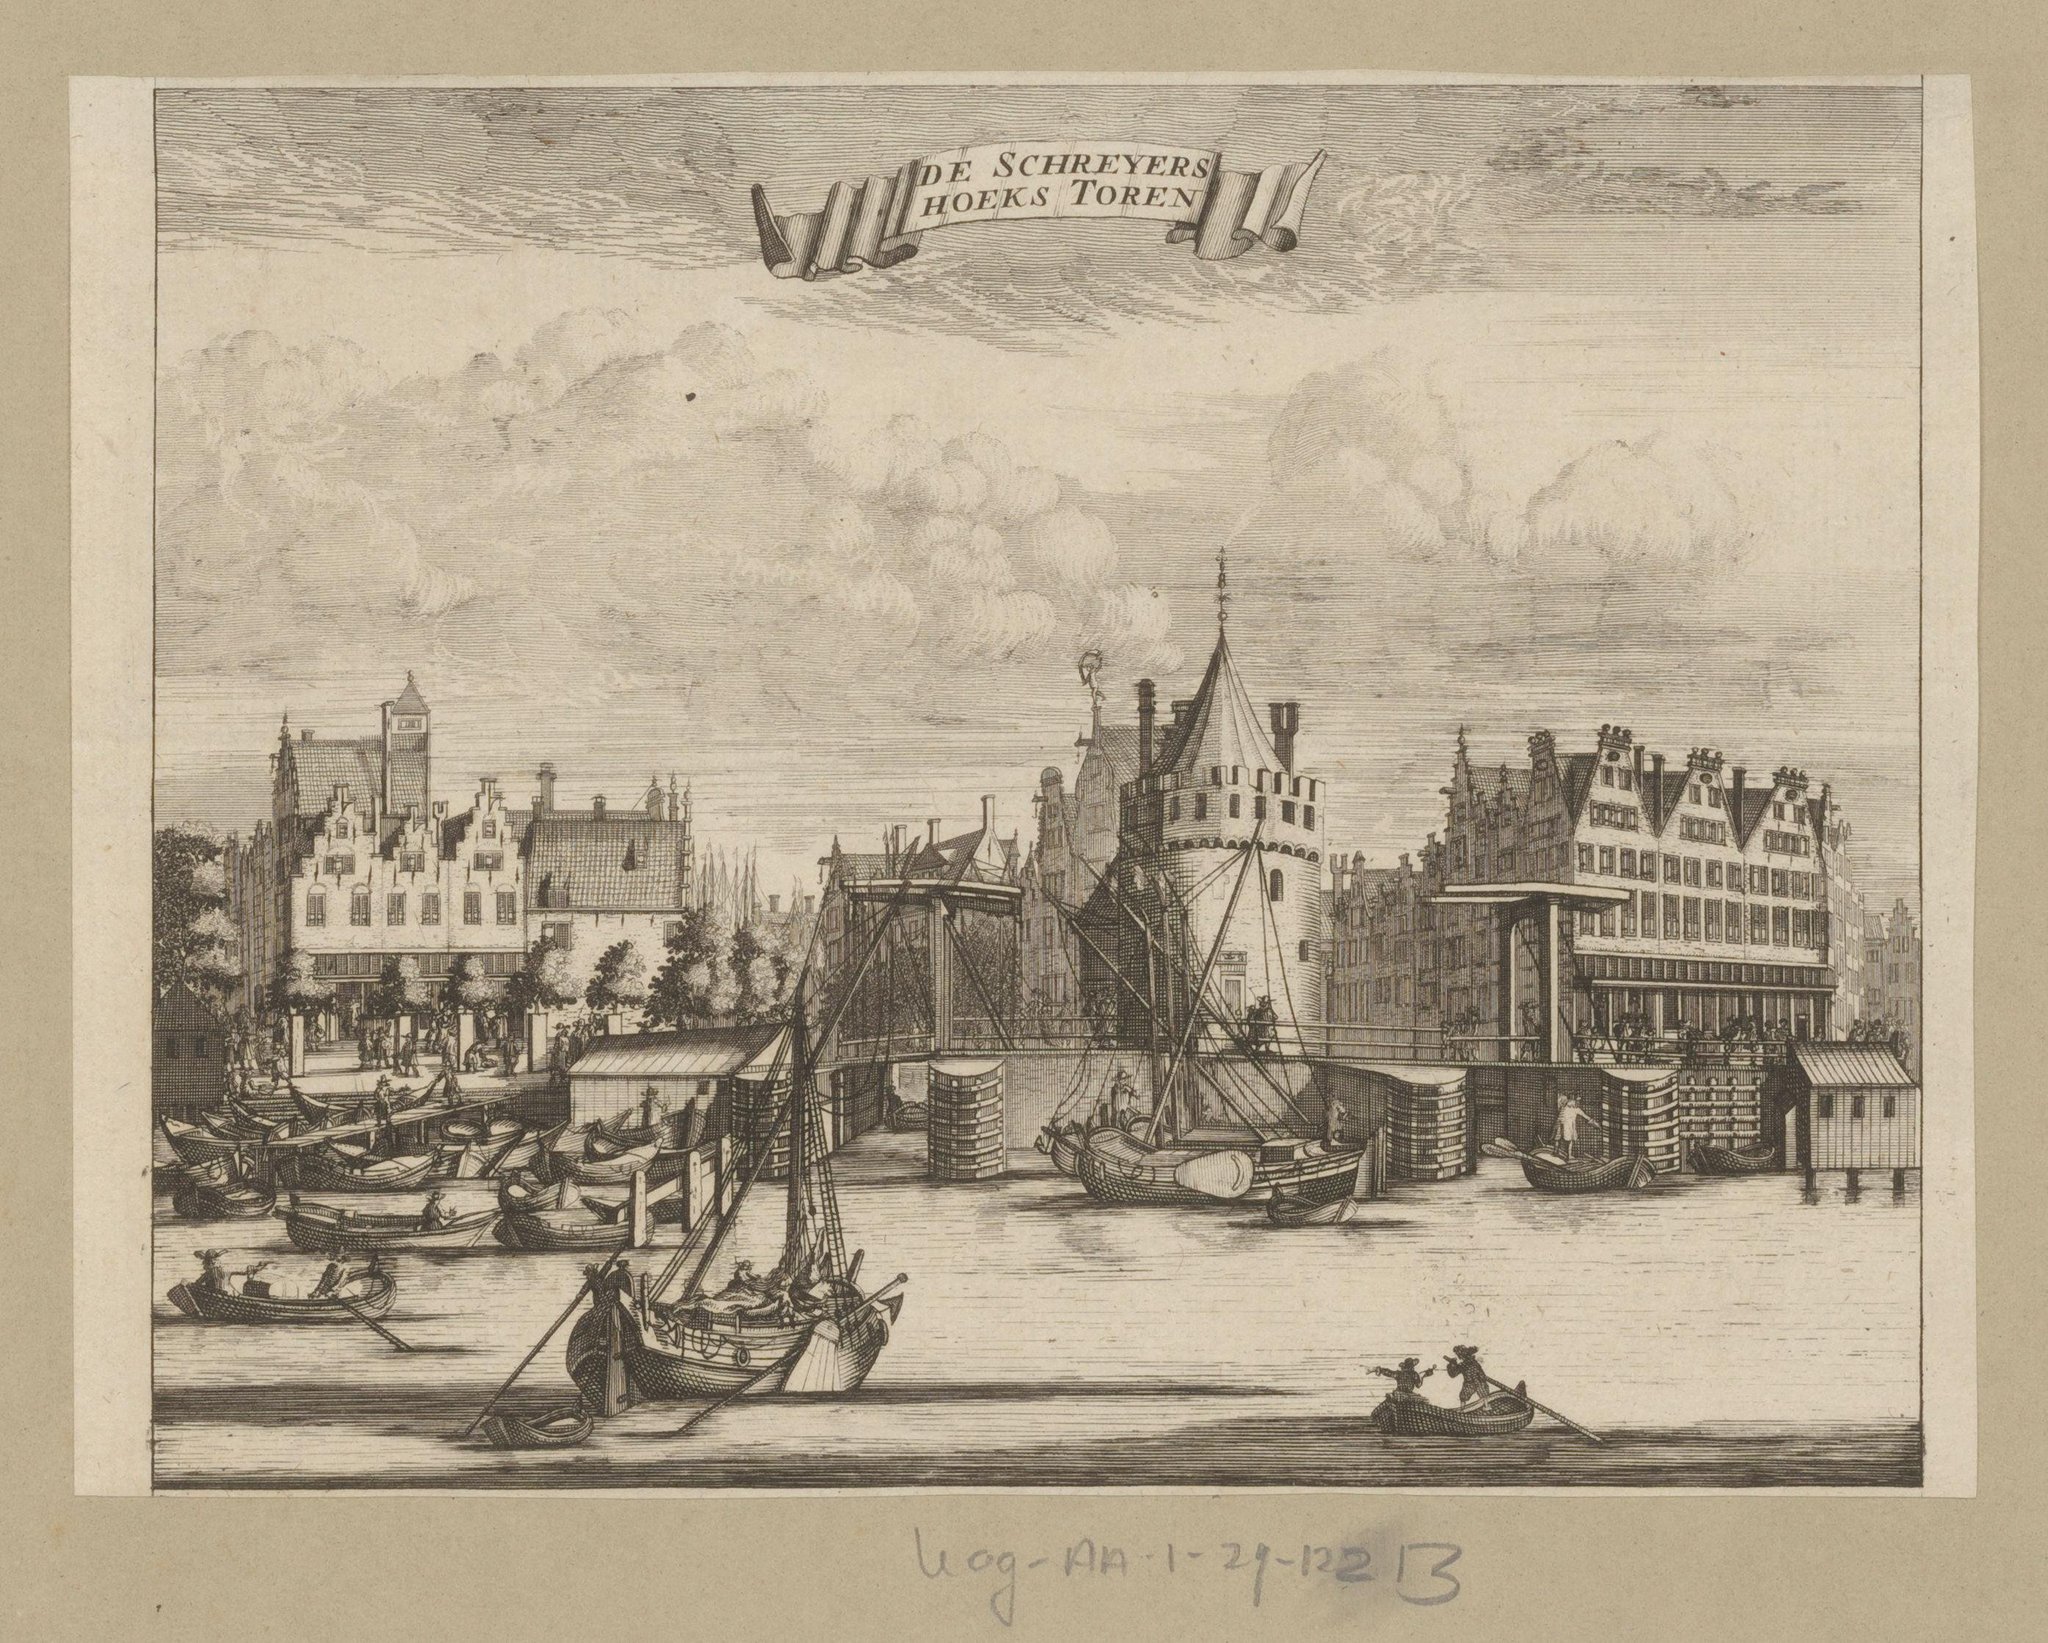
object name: print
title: De Schreyers hoeks Toren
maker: Anonymous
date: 1693-1694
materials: paper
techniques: engraving, etching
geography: northern netherlands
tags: sluice, weir, bridge in city across river, canal, etc. (+ city(-scape) with figures, staffage), sailing-ship, sailing-boat, towers ~ fortified city, rowing-boat, canoe, etc.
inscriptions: collector's mark: Lugt 1641b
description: Onderwerpsrubriek binnen de Atlas Amsterdam: Schreierstoren.